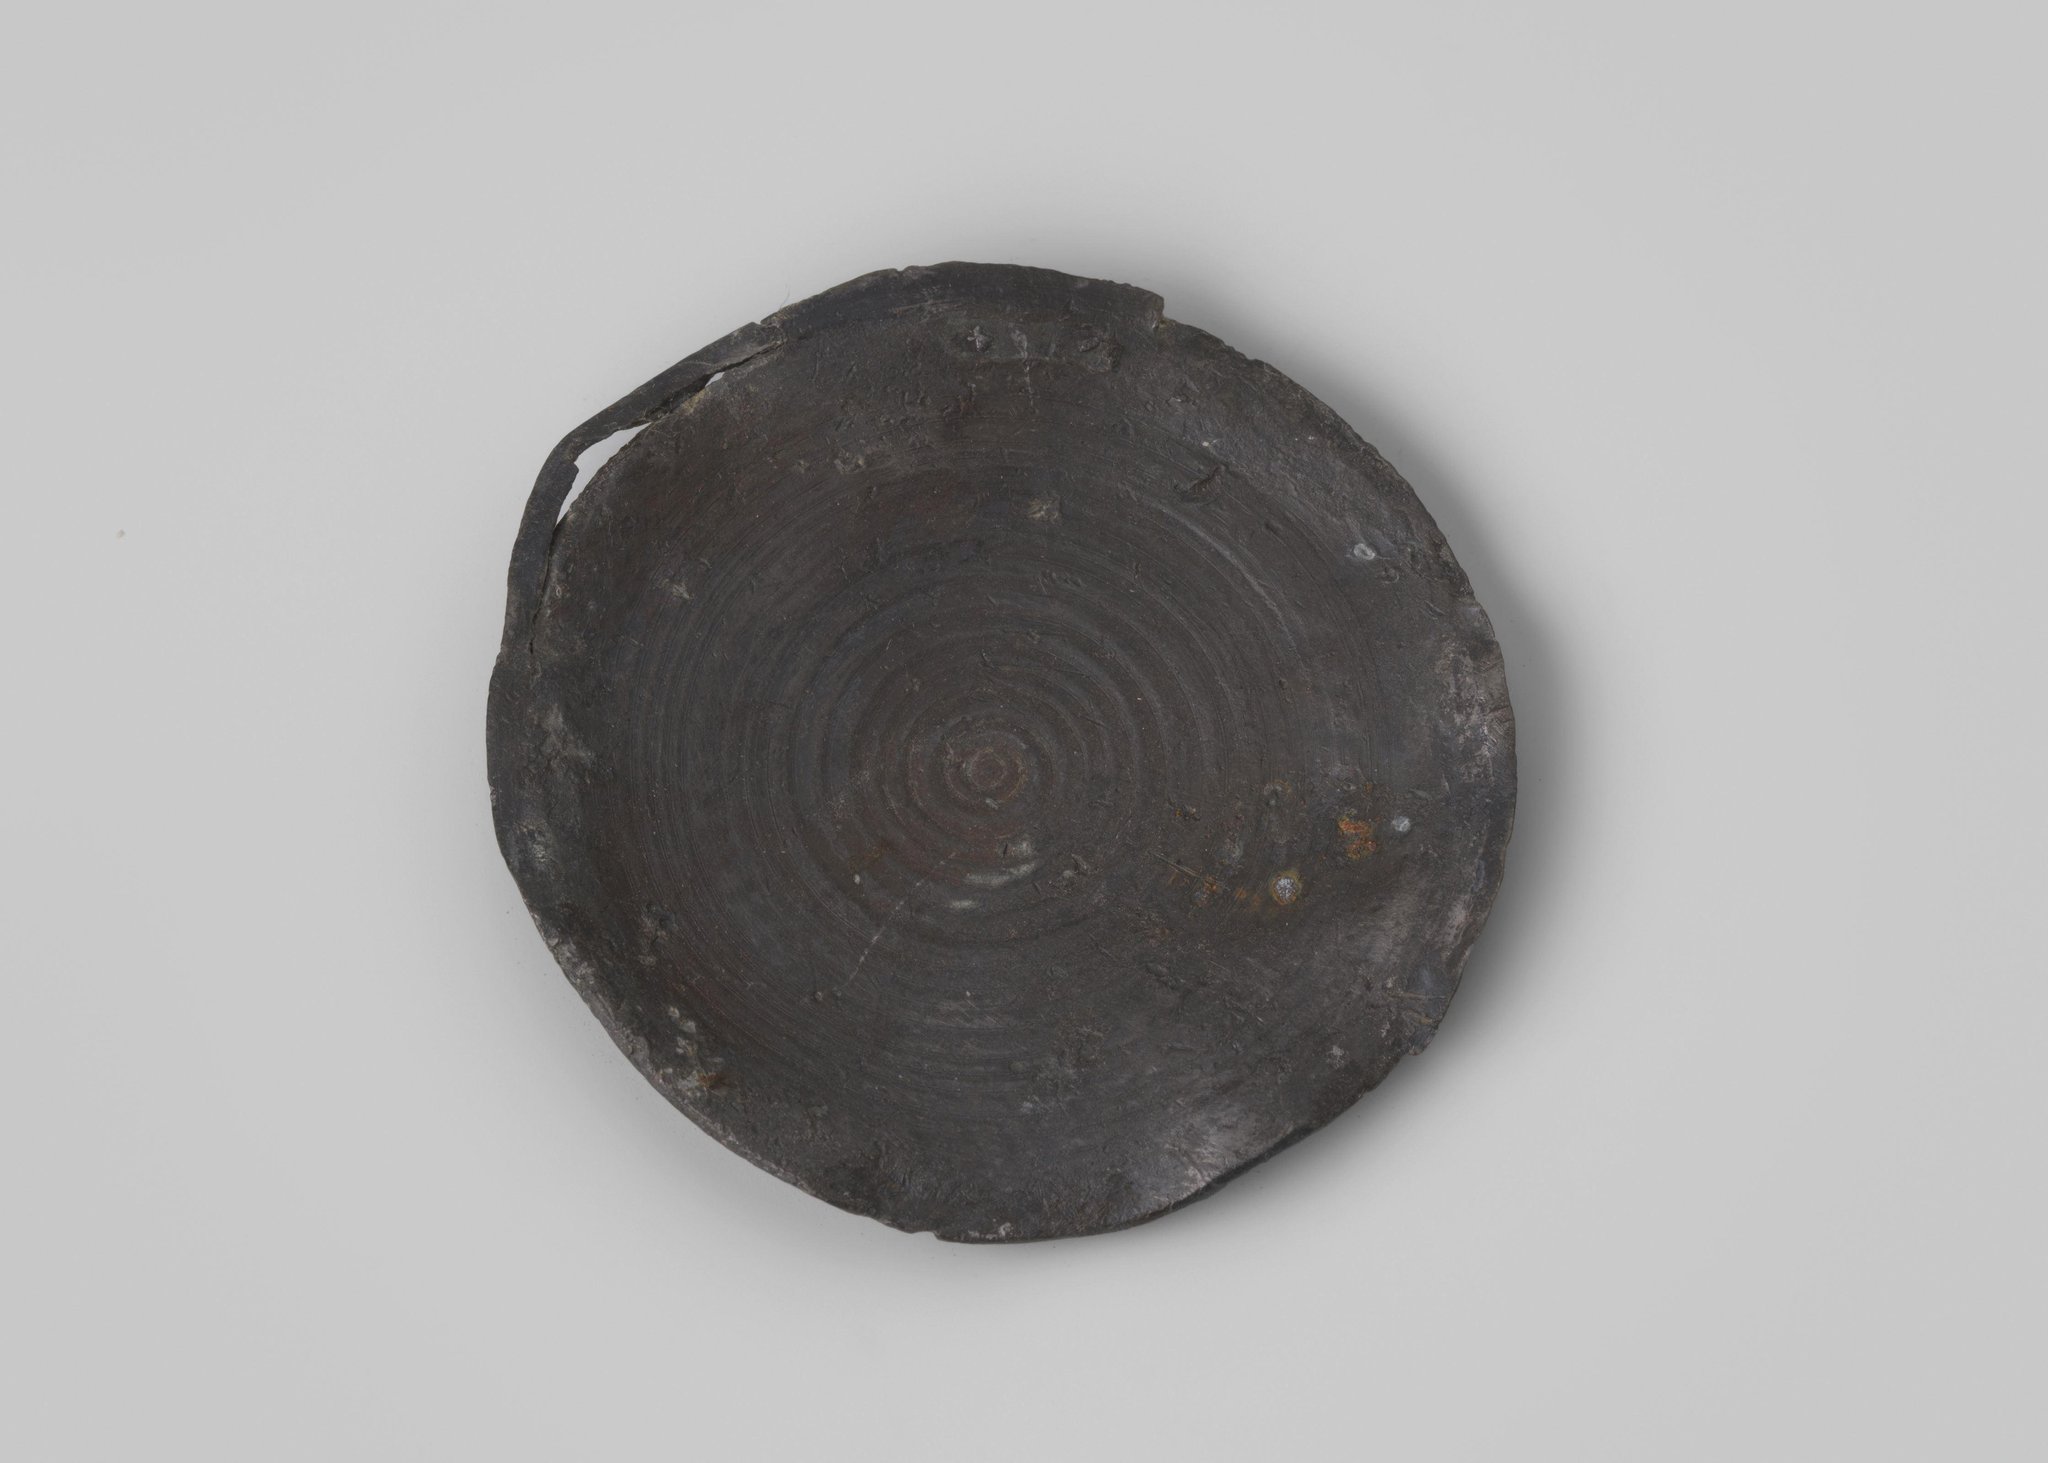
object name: lid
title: Deksel van een verpakking uit het wrak van de Oost-Indiëvaarder Hollandia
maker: Anonymous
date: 1700-1743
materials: tin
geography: netherlands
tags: verenigde oostindische compagnie, hollandia (schip), annet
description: Container, lid; circular, slightly convex, fragm of soldered rim, spiral pattern underneath as a result of the manufacture process (turning).